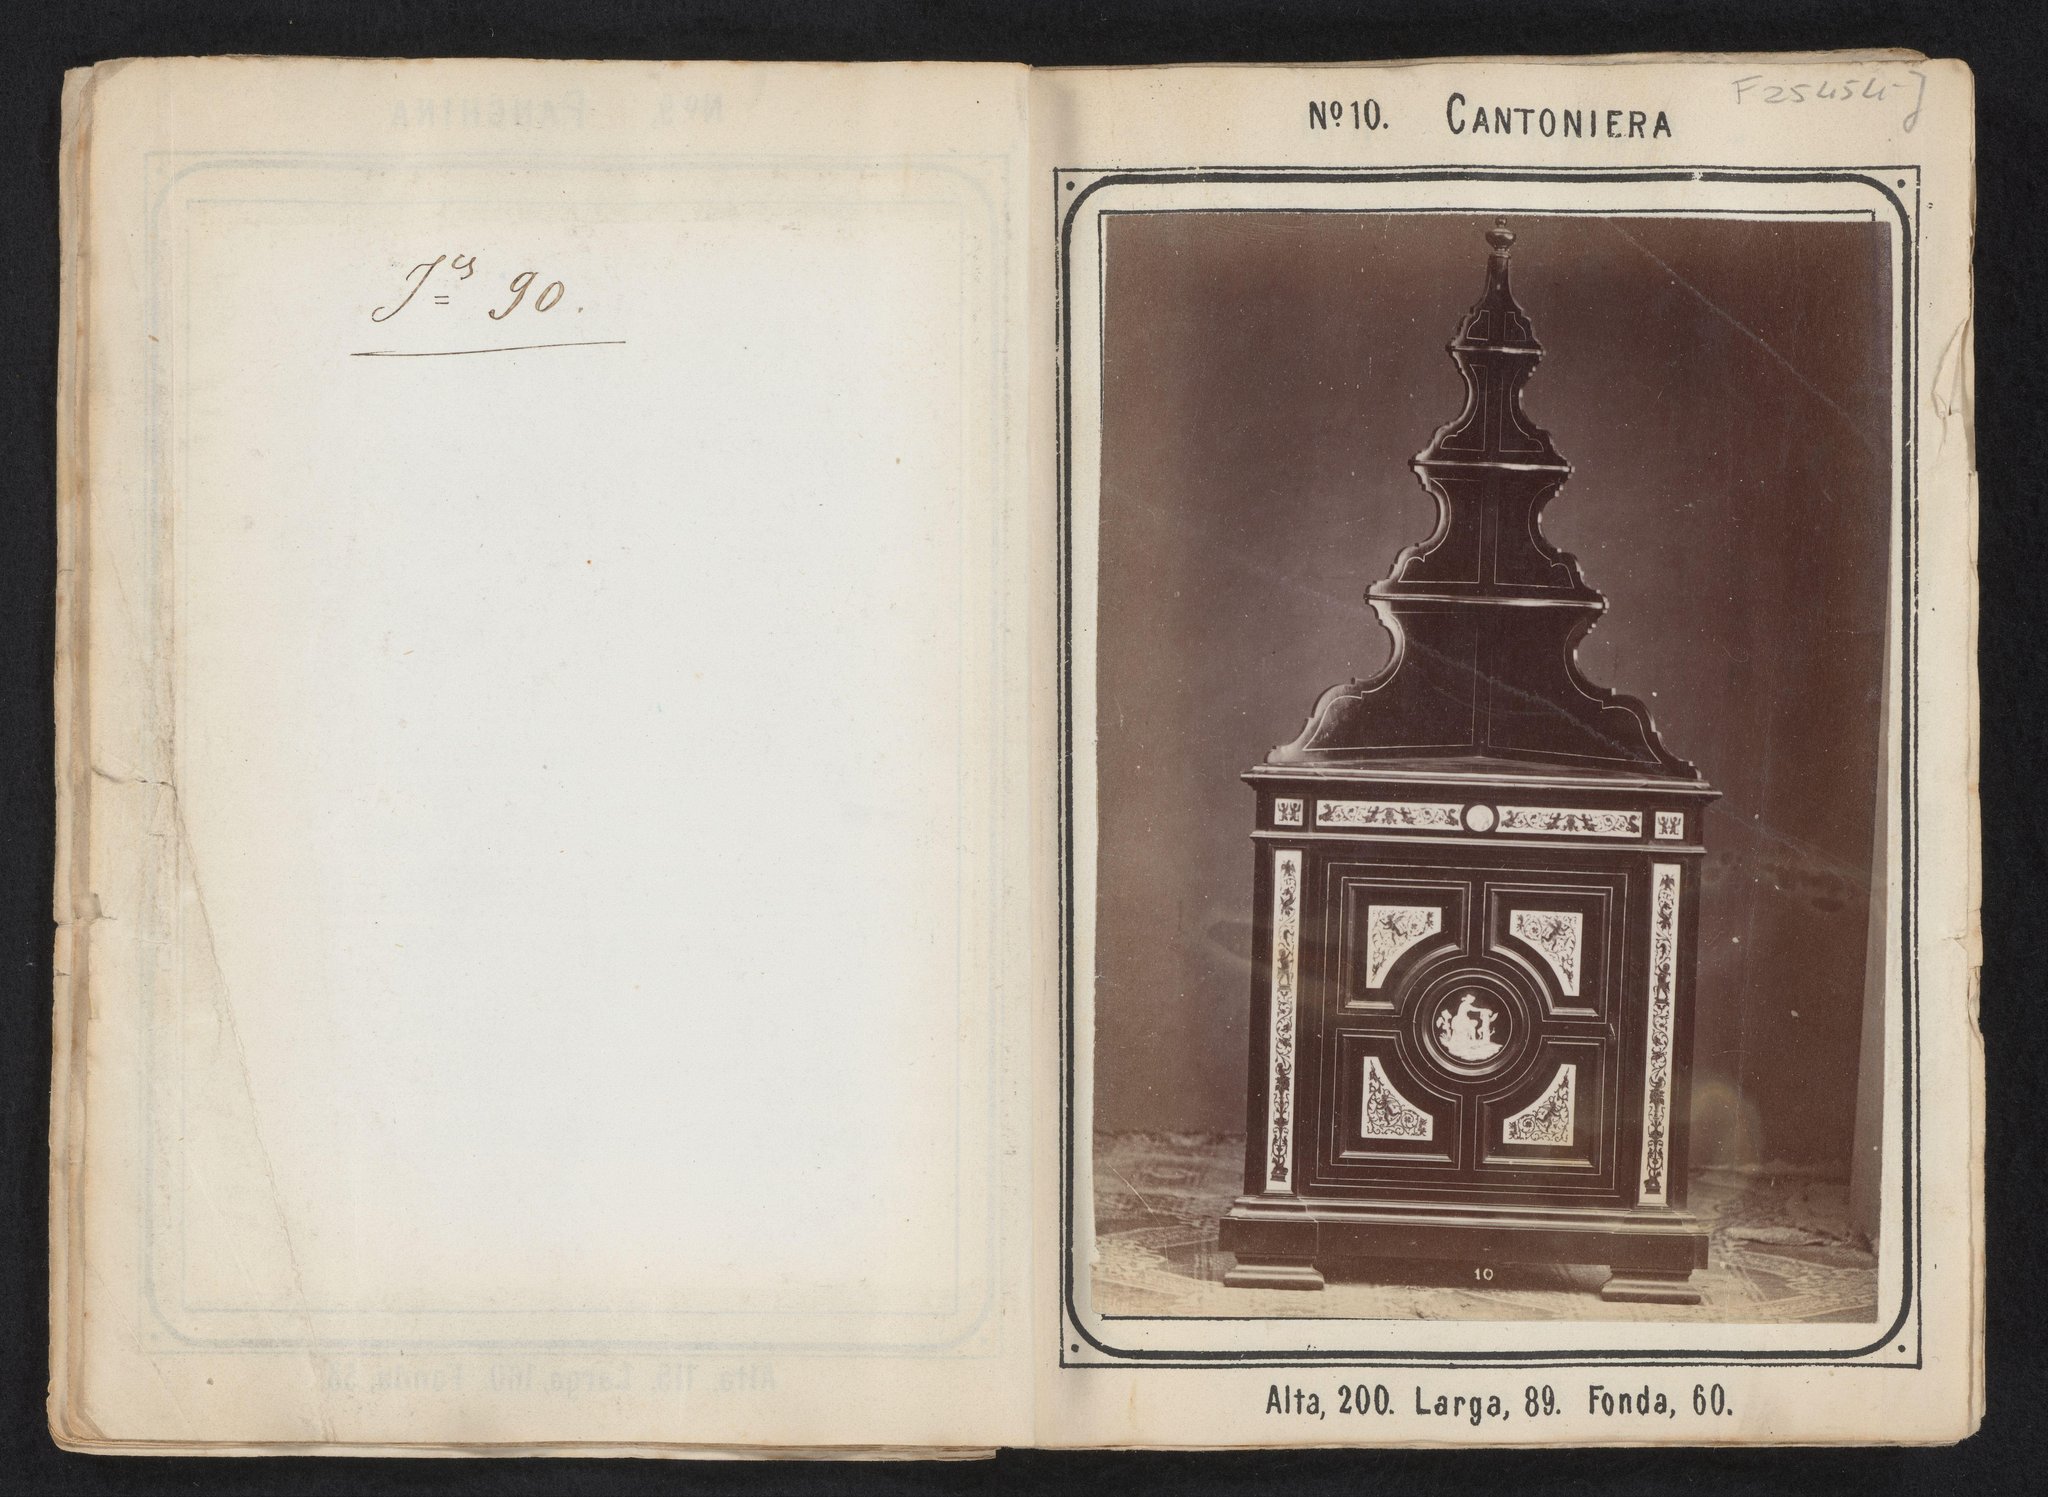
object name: page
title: No 10 Cantoniera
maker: Anonymous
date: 1878-1885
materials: paper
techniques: albumen print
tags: ornamental cupboard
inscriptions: inscription: ‘Ies. 200’, inscription: ‘Alta, 200. Larga, 89. Fonda, 60.’